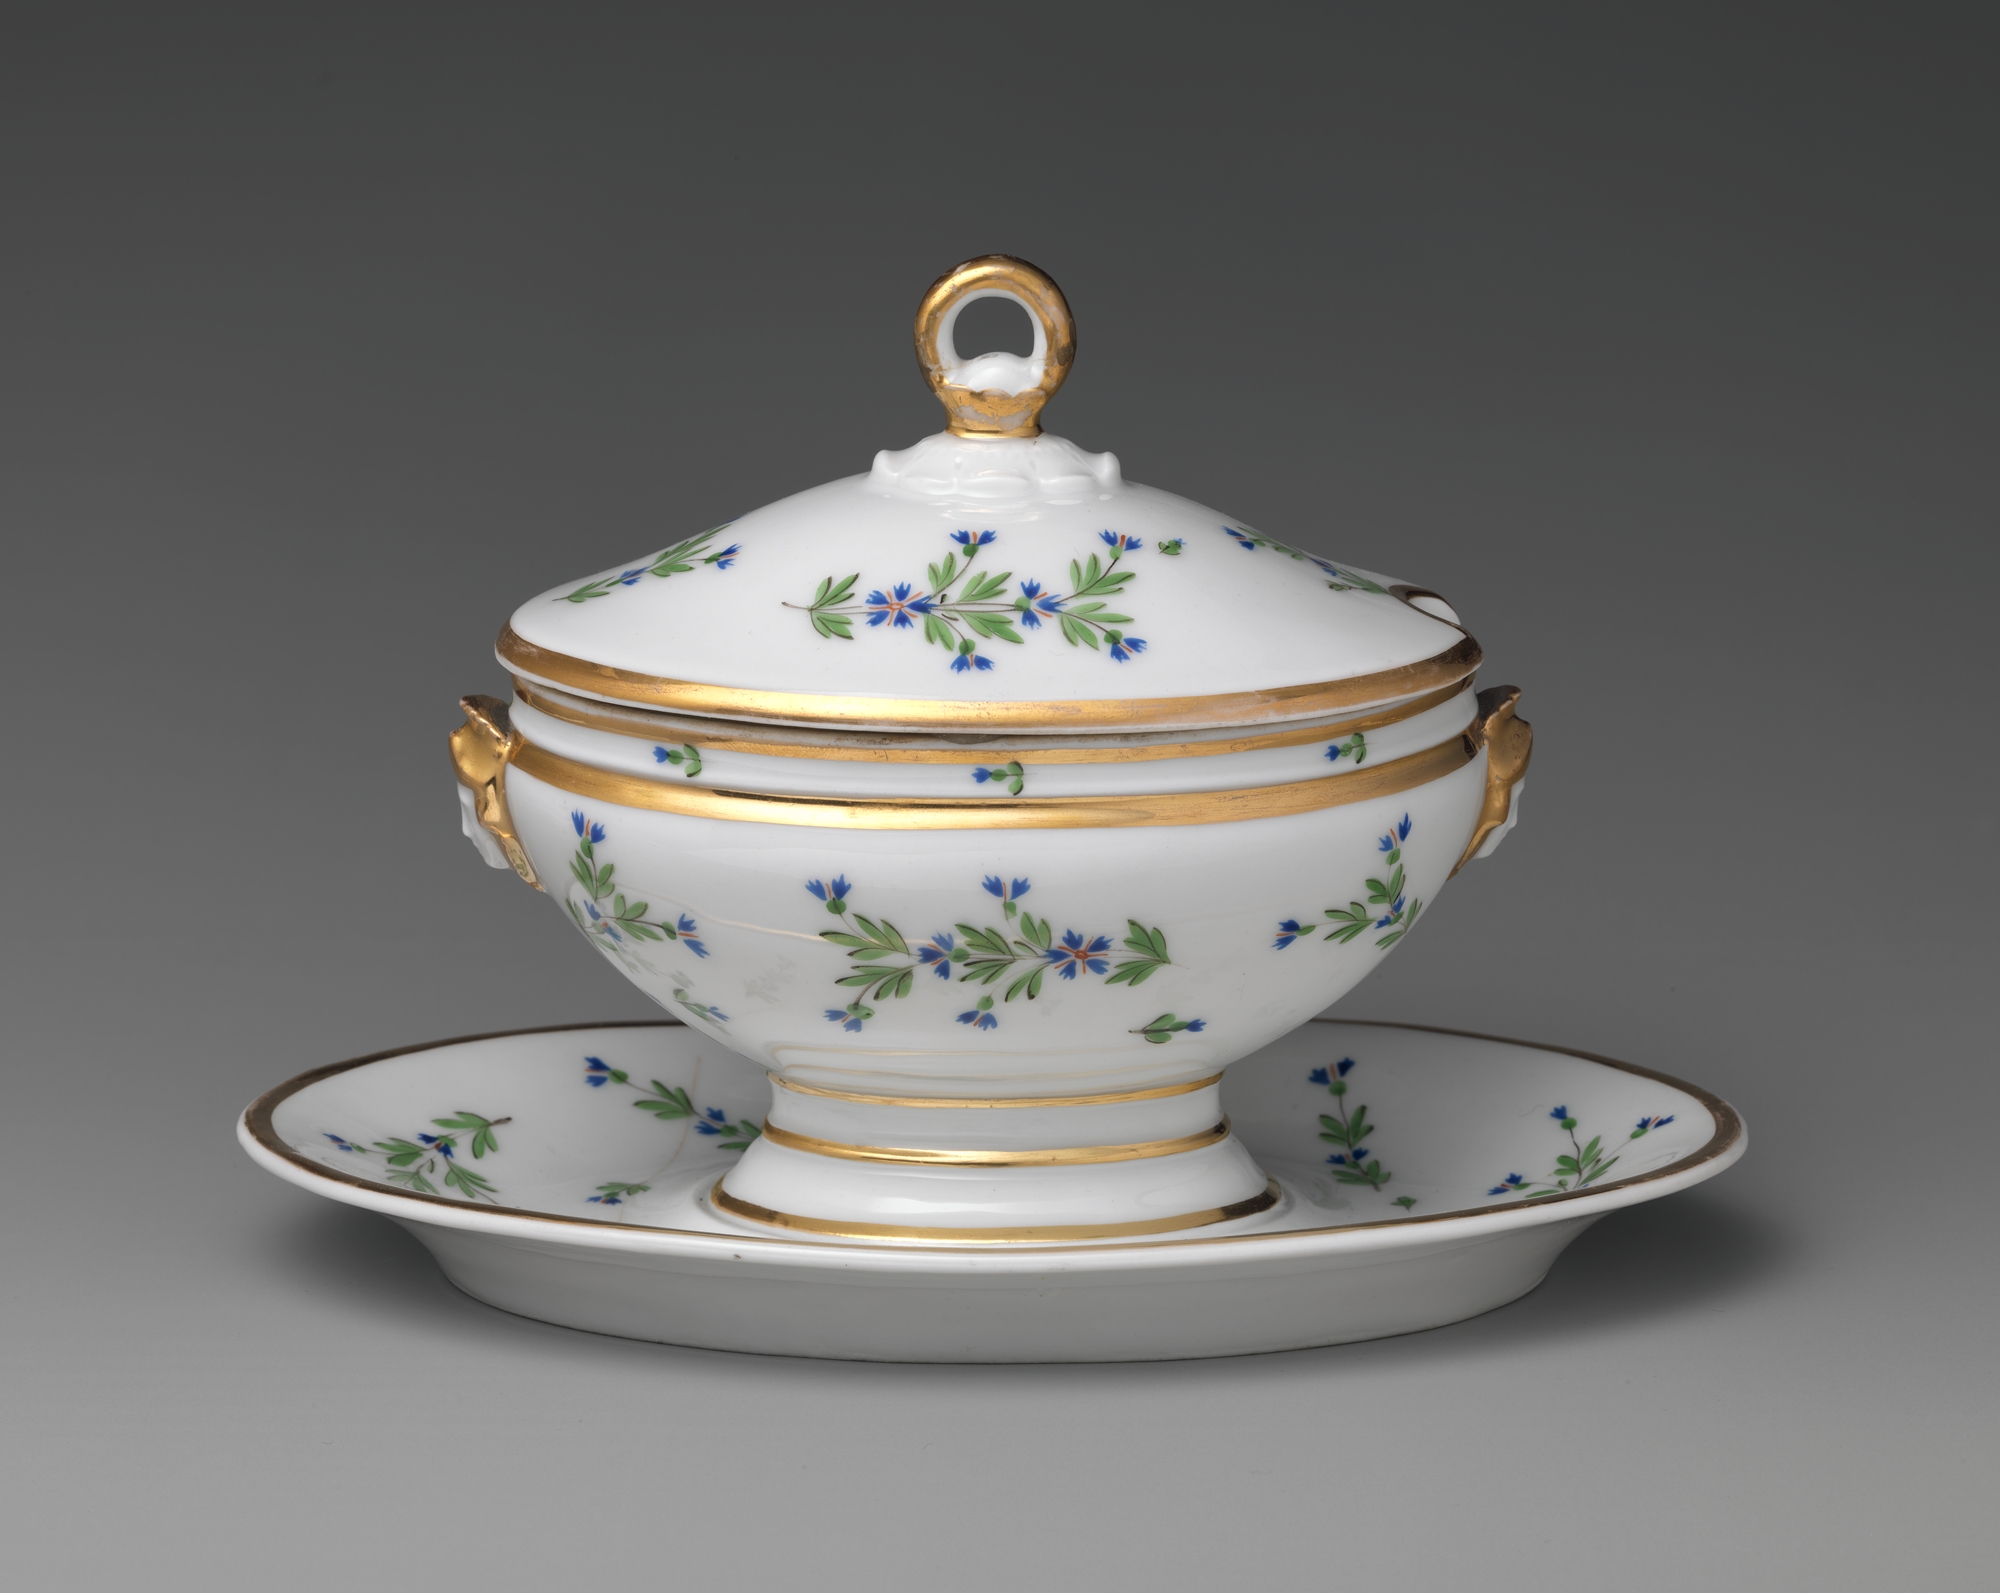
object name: bowl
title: Covered Bowl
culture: french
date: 1815-1830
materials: porcelain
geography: france